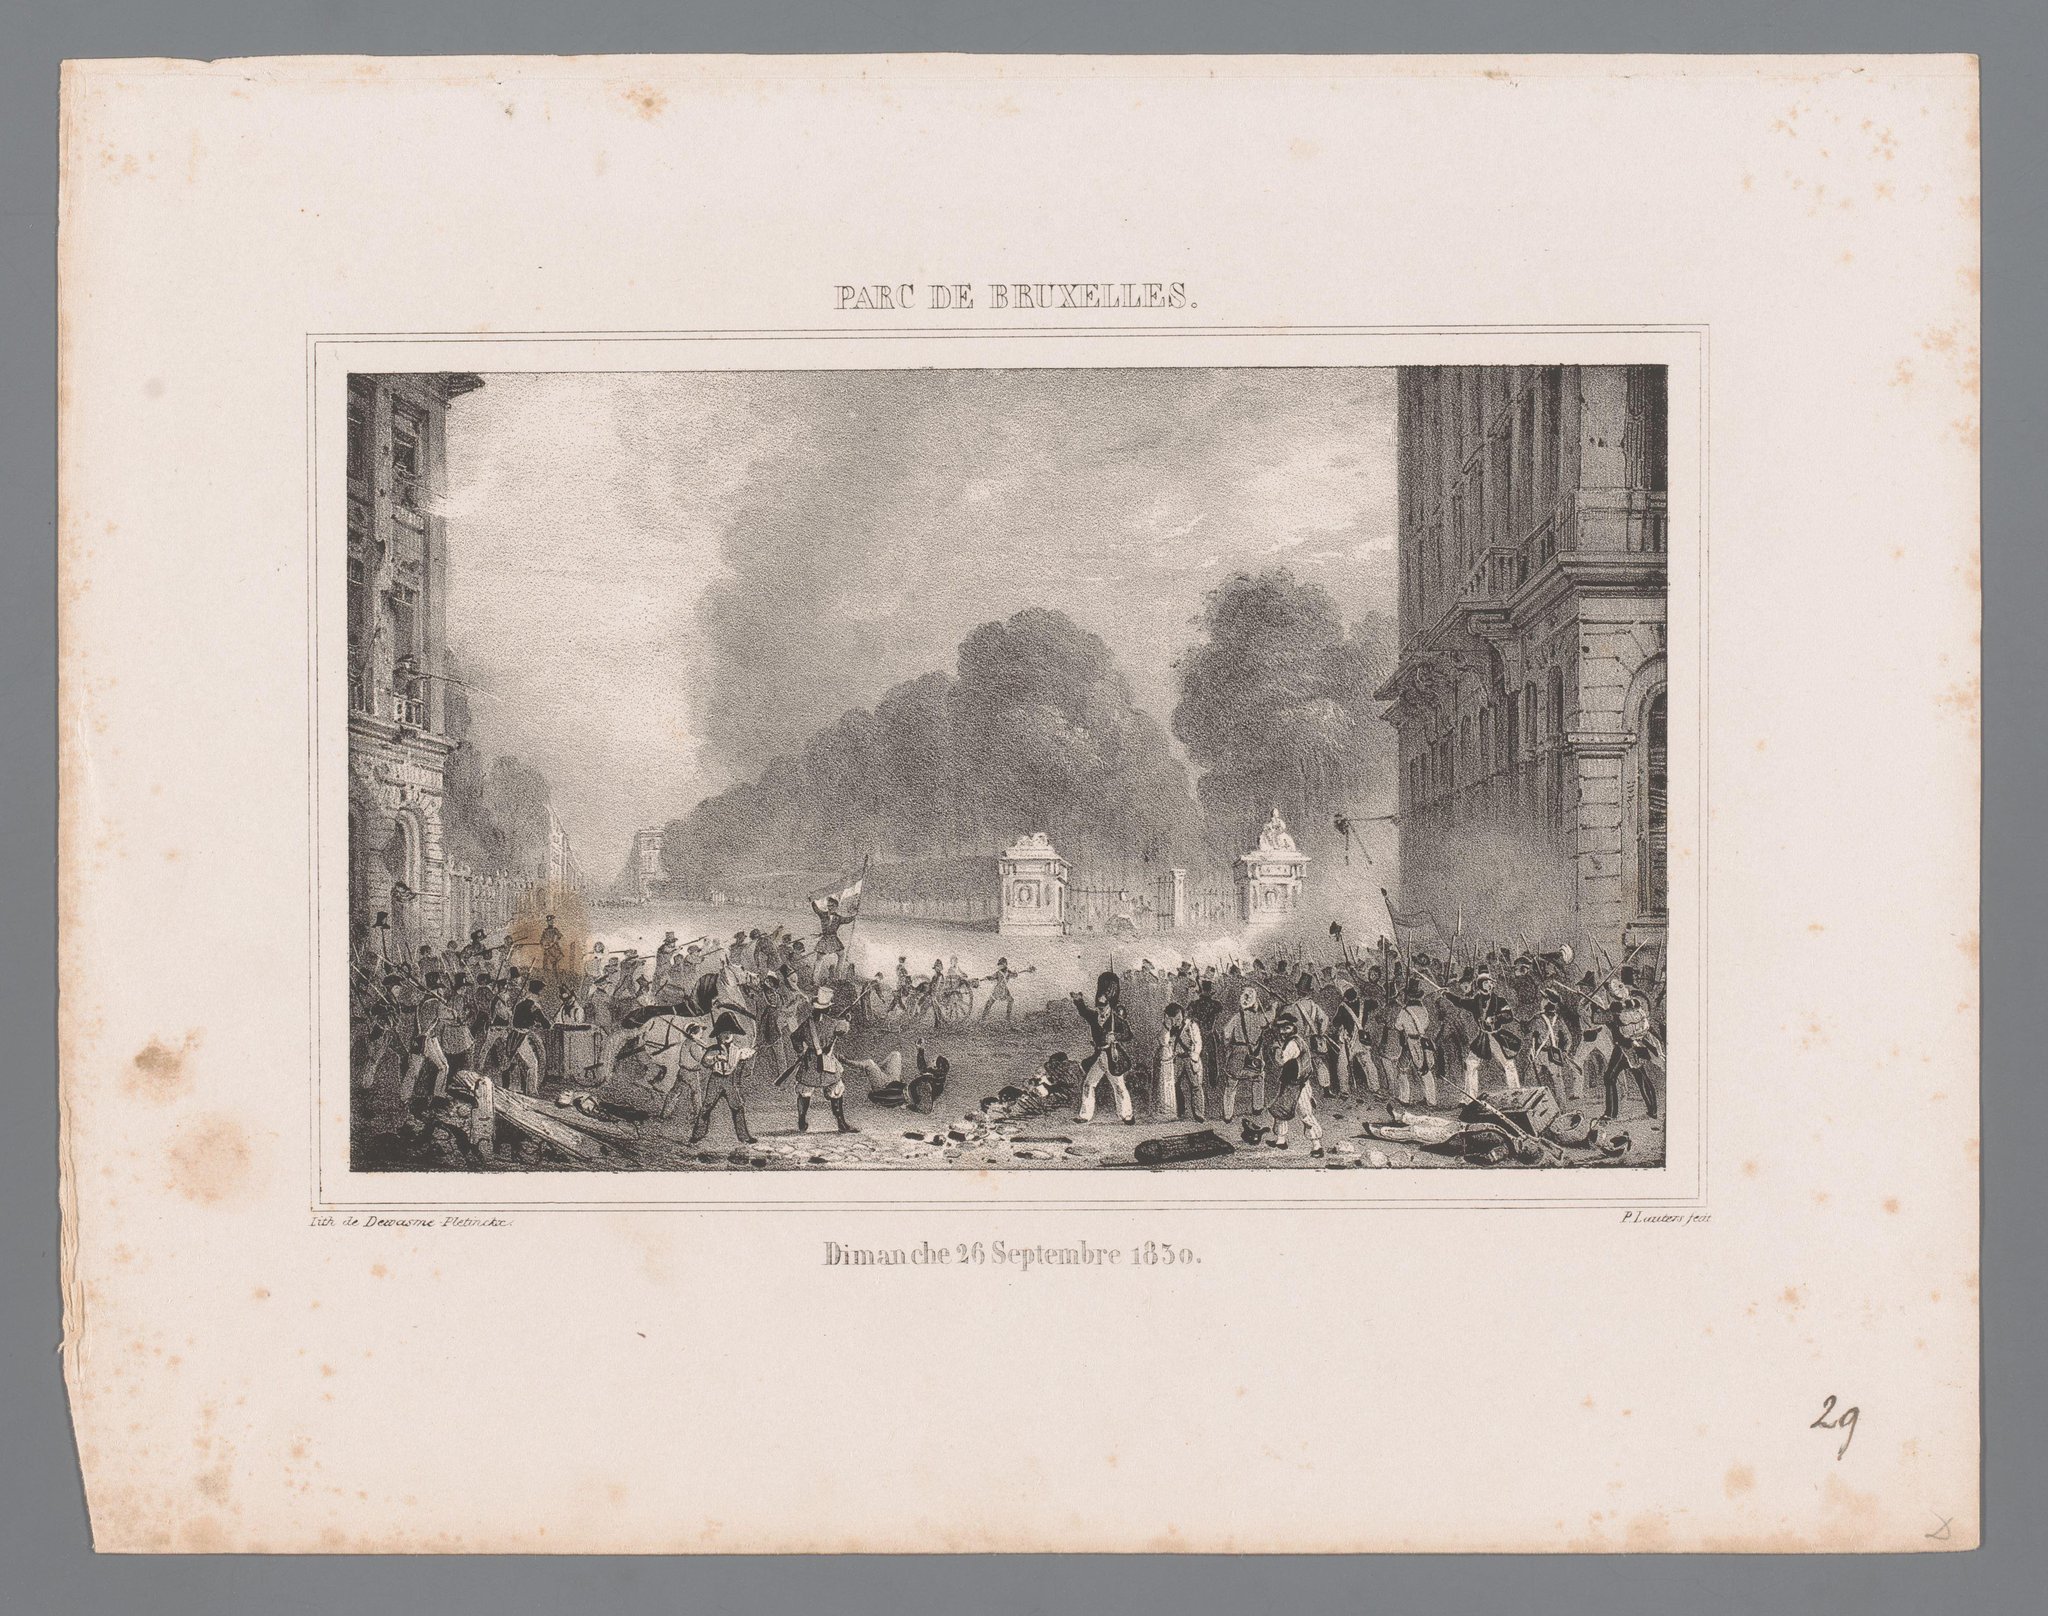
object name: print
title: Evénemens de Bruxelles, Anvers (...)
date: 1830-1831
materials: paper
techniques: lithograph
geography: brussels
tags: barricades ~ riot, battle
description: Prent maakt deel uit van een serie met prenten over de gebeurtenissen tijdens de Belgische Revolutie in Brussel, Antwerpen en andere steden in de periode 25 augustus 1830 tot 27 maart 1831.